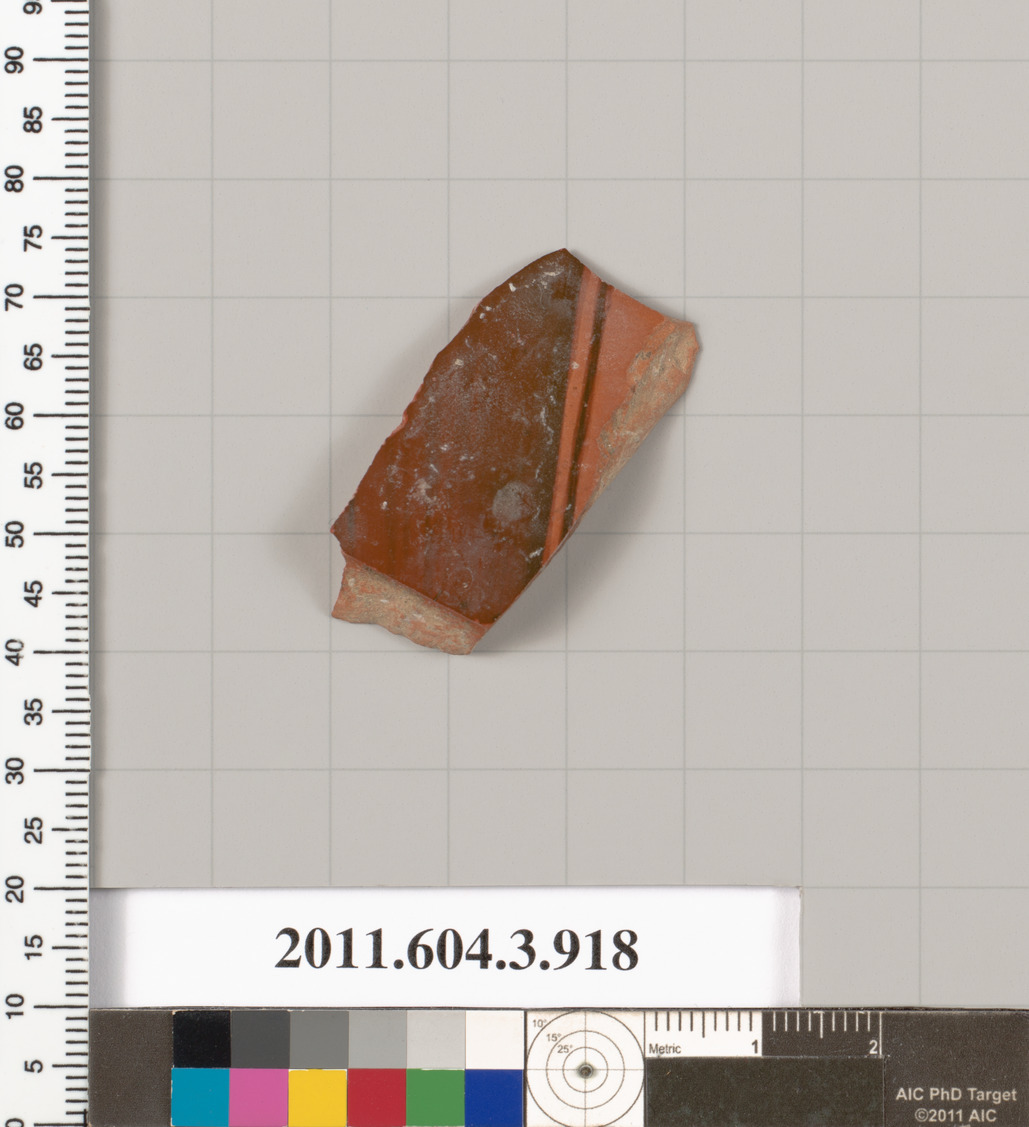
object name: lekythos fragment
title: Terracotta fragment of a lekythos (oil flask)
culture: greek, attic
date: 600-401 BCE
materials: terracotta